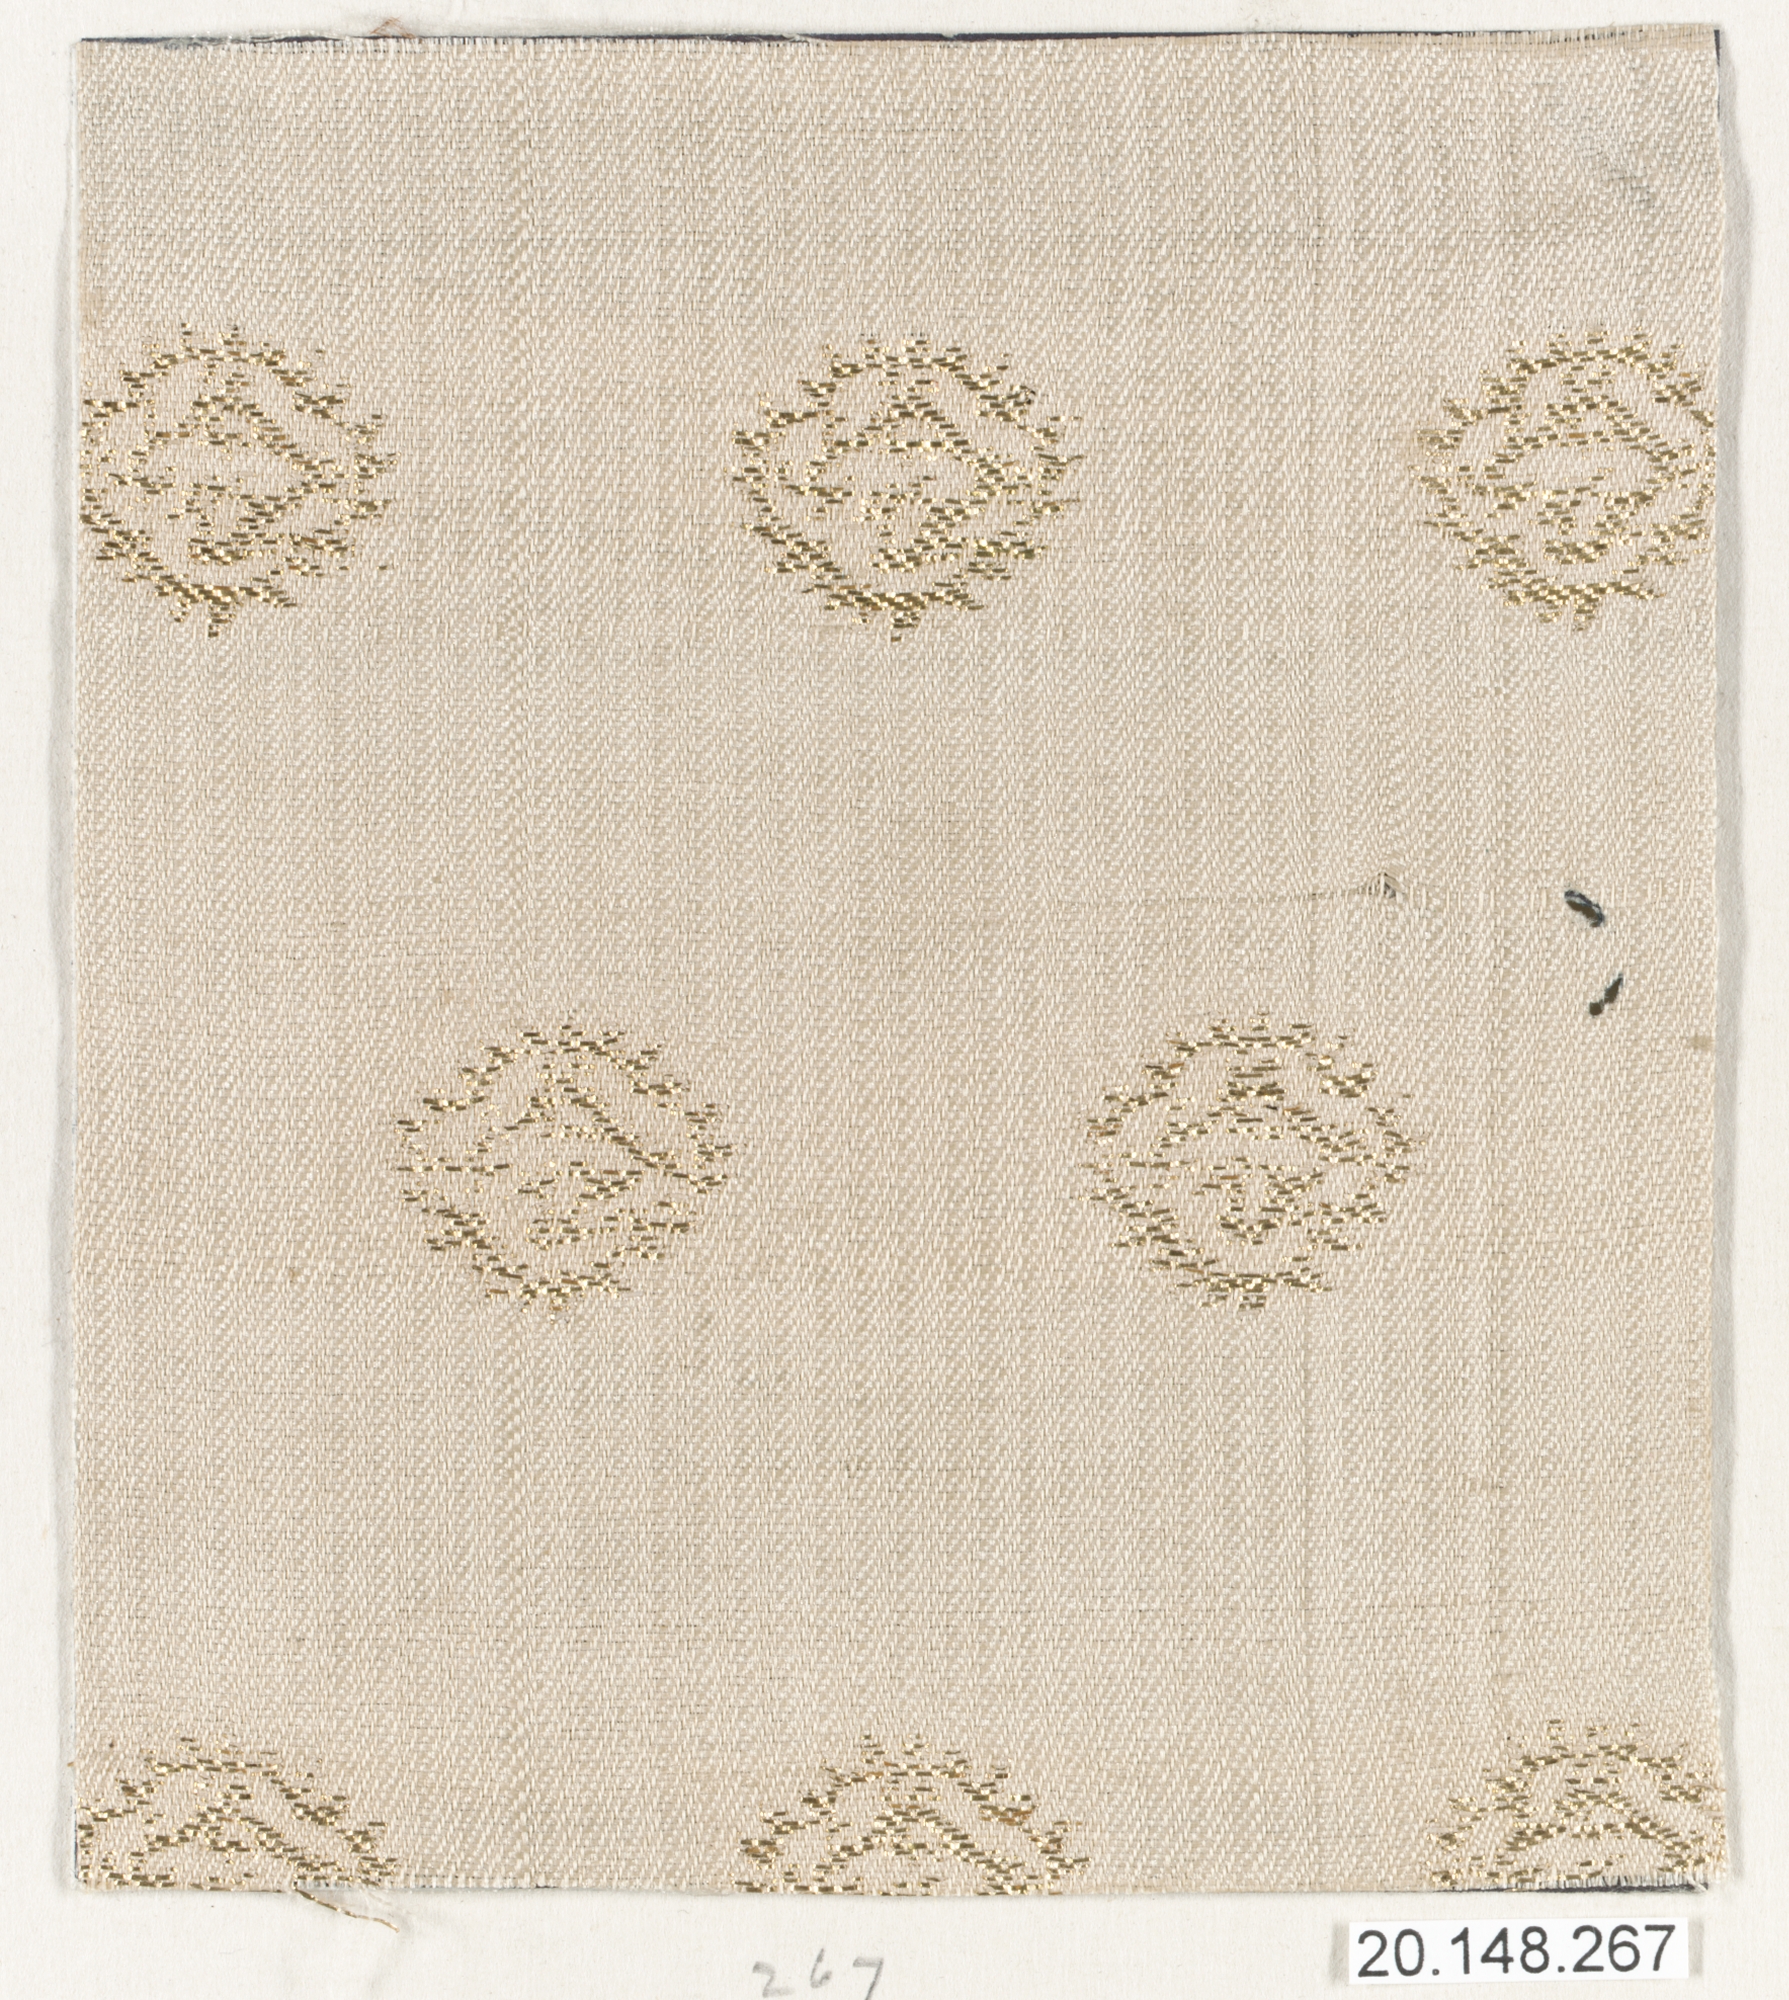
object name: piece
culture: japanese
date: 1701-1800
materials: silk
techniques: compound weave